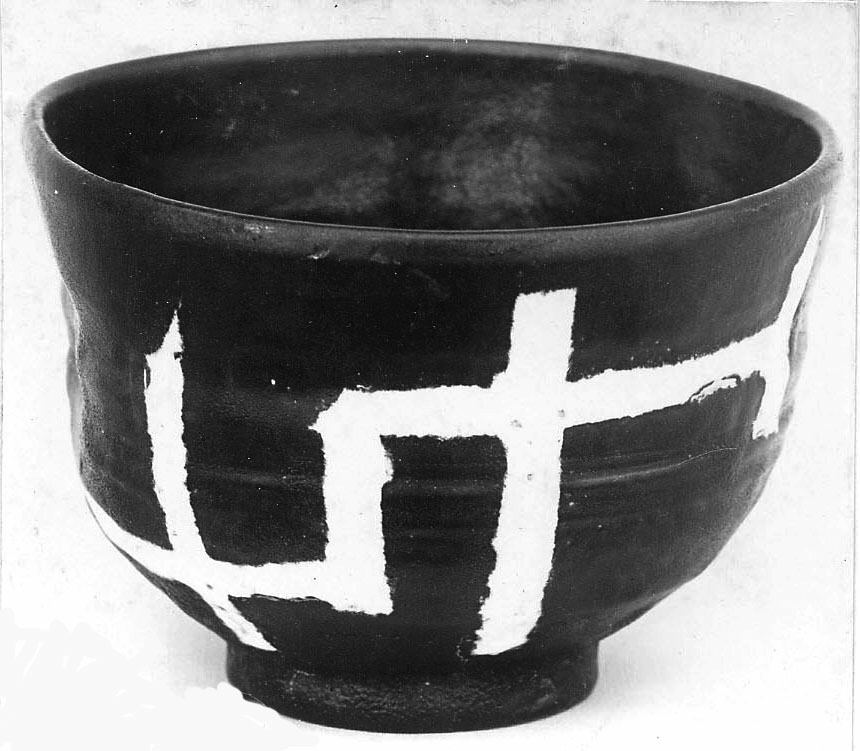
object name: teabowl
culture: japanese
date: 1601-1700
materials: glaze, pottery